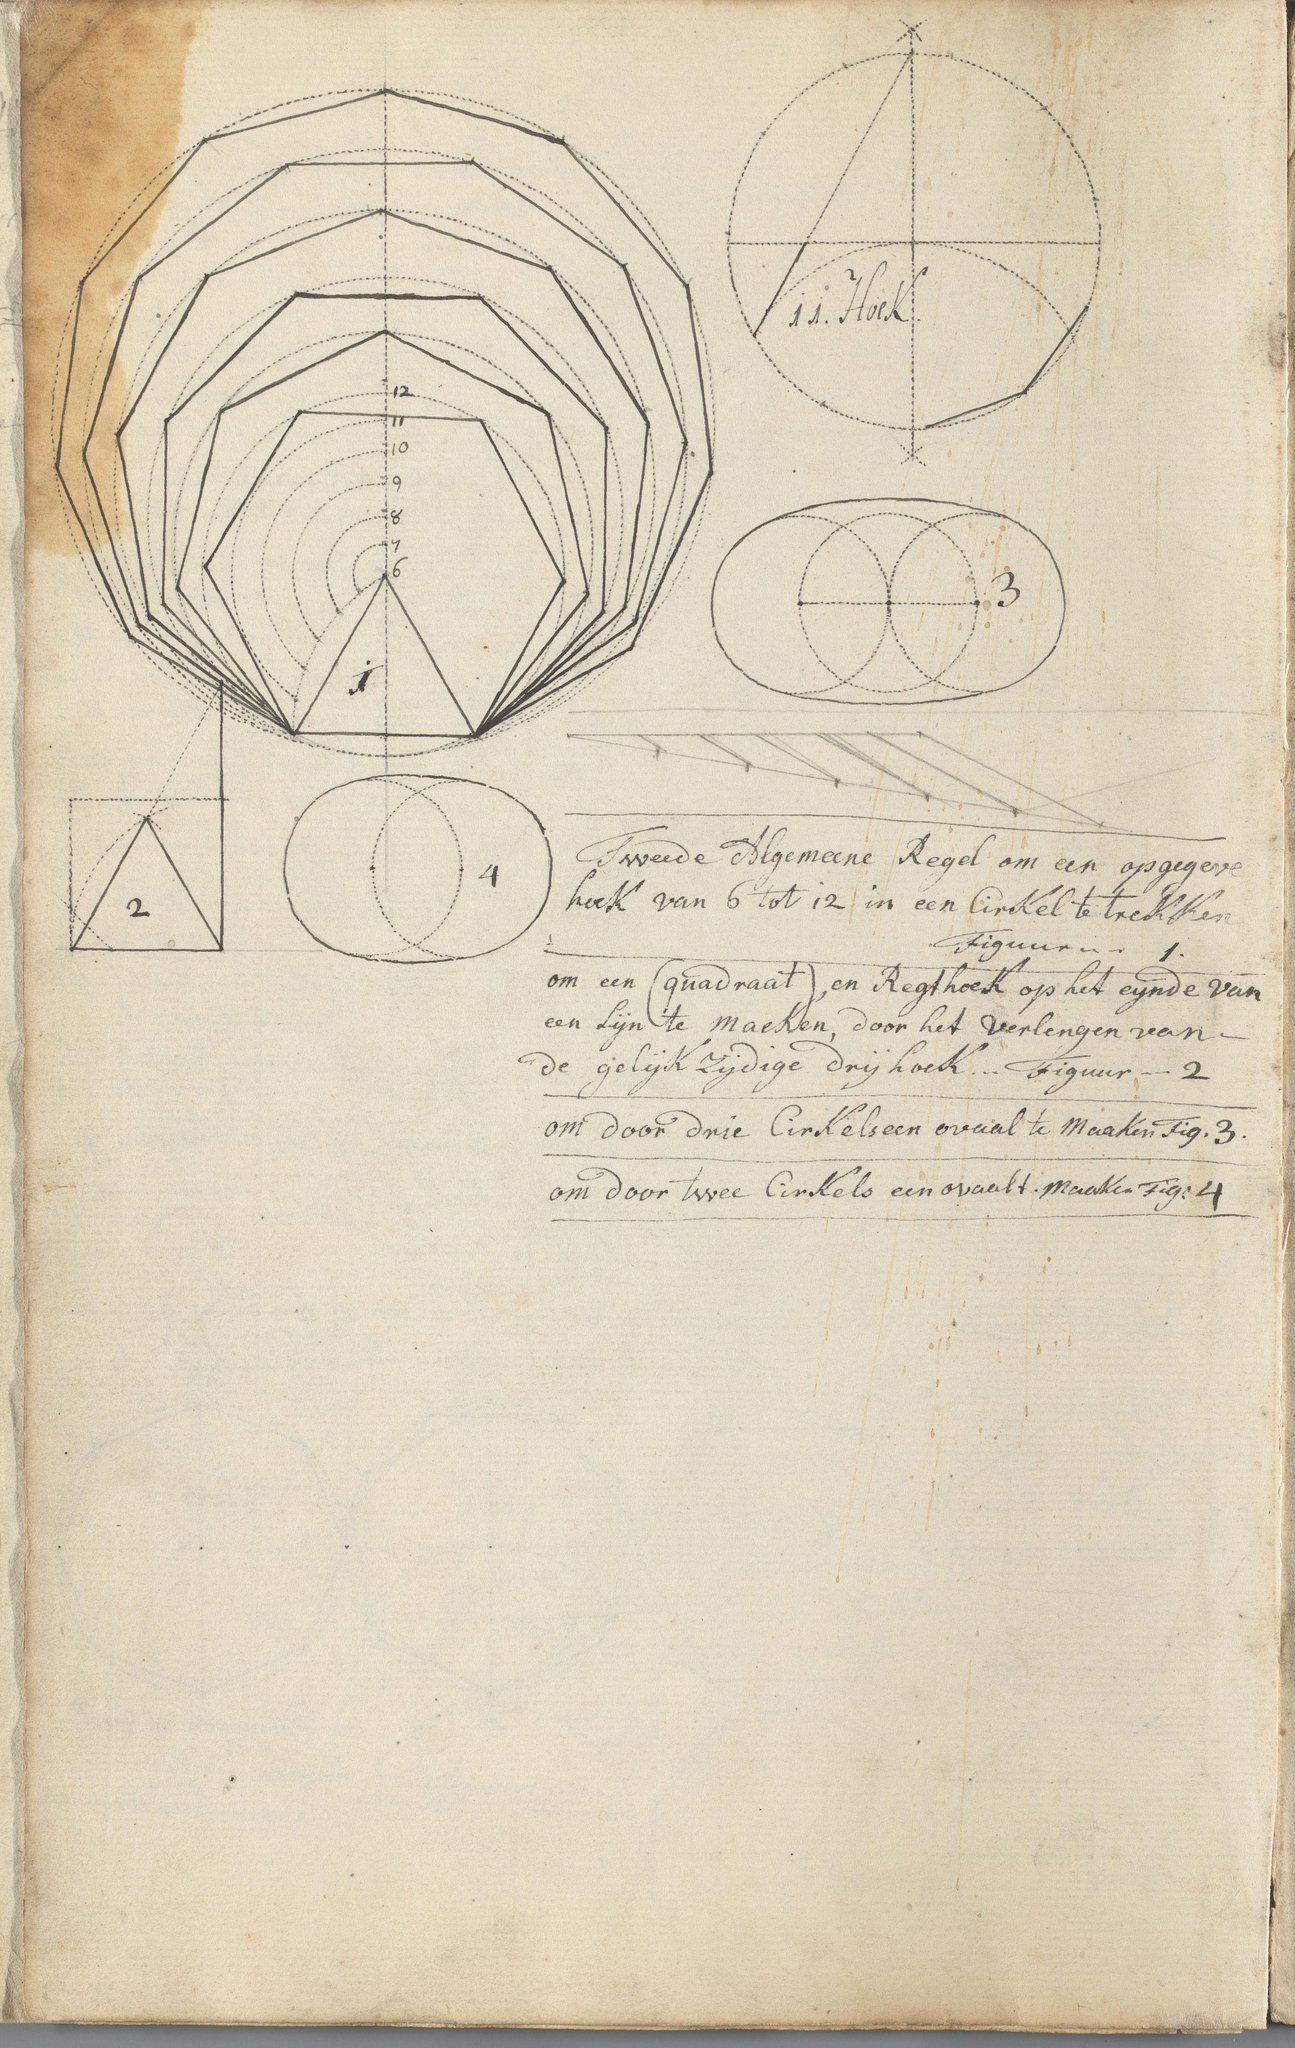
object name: sketchbook leaf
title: Geometrische figuren, voorzien van handgeschreven uitleg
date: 1780-1800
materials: ink, paper, pencil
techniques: drawing, pen, writing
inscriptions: inscription: ‘Tweede Algemeene Regen om een opgegeve / hoek van 6 tot 12 in een cirkel te trekken [...]’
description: Blad 16 verso uit een schetsboek met 17 bladen.